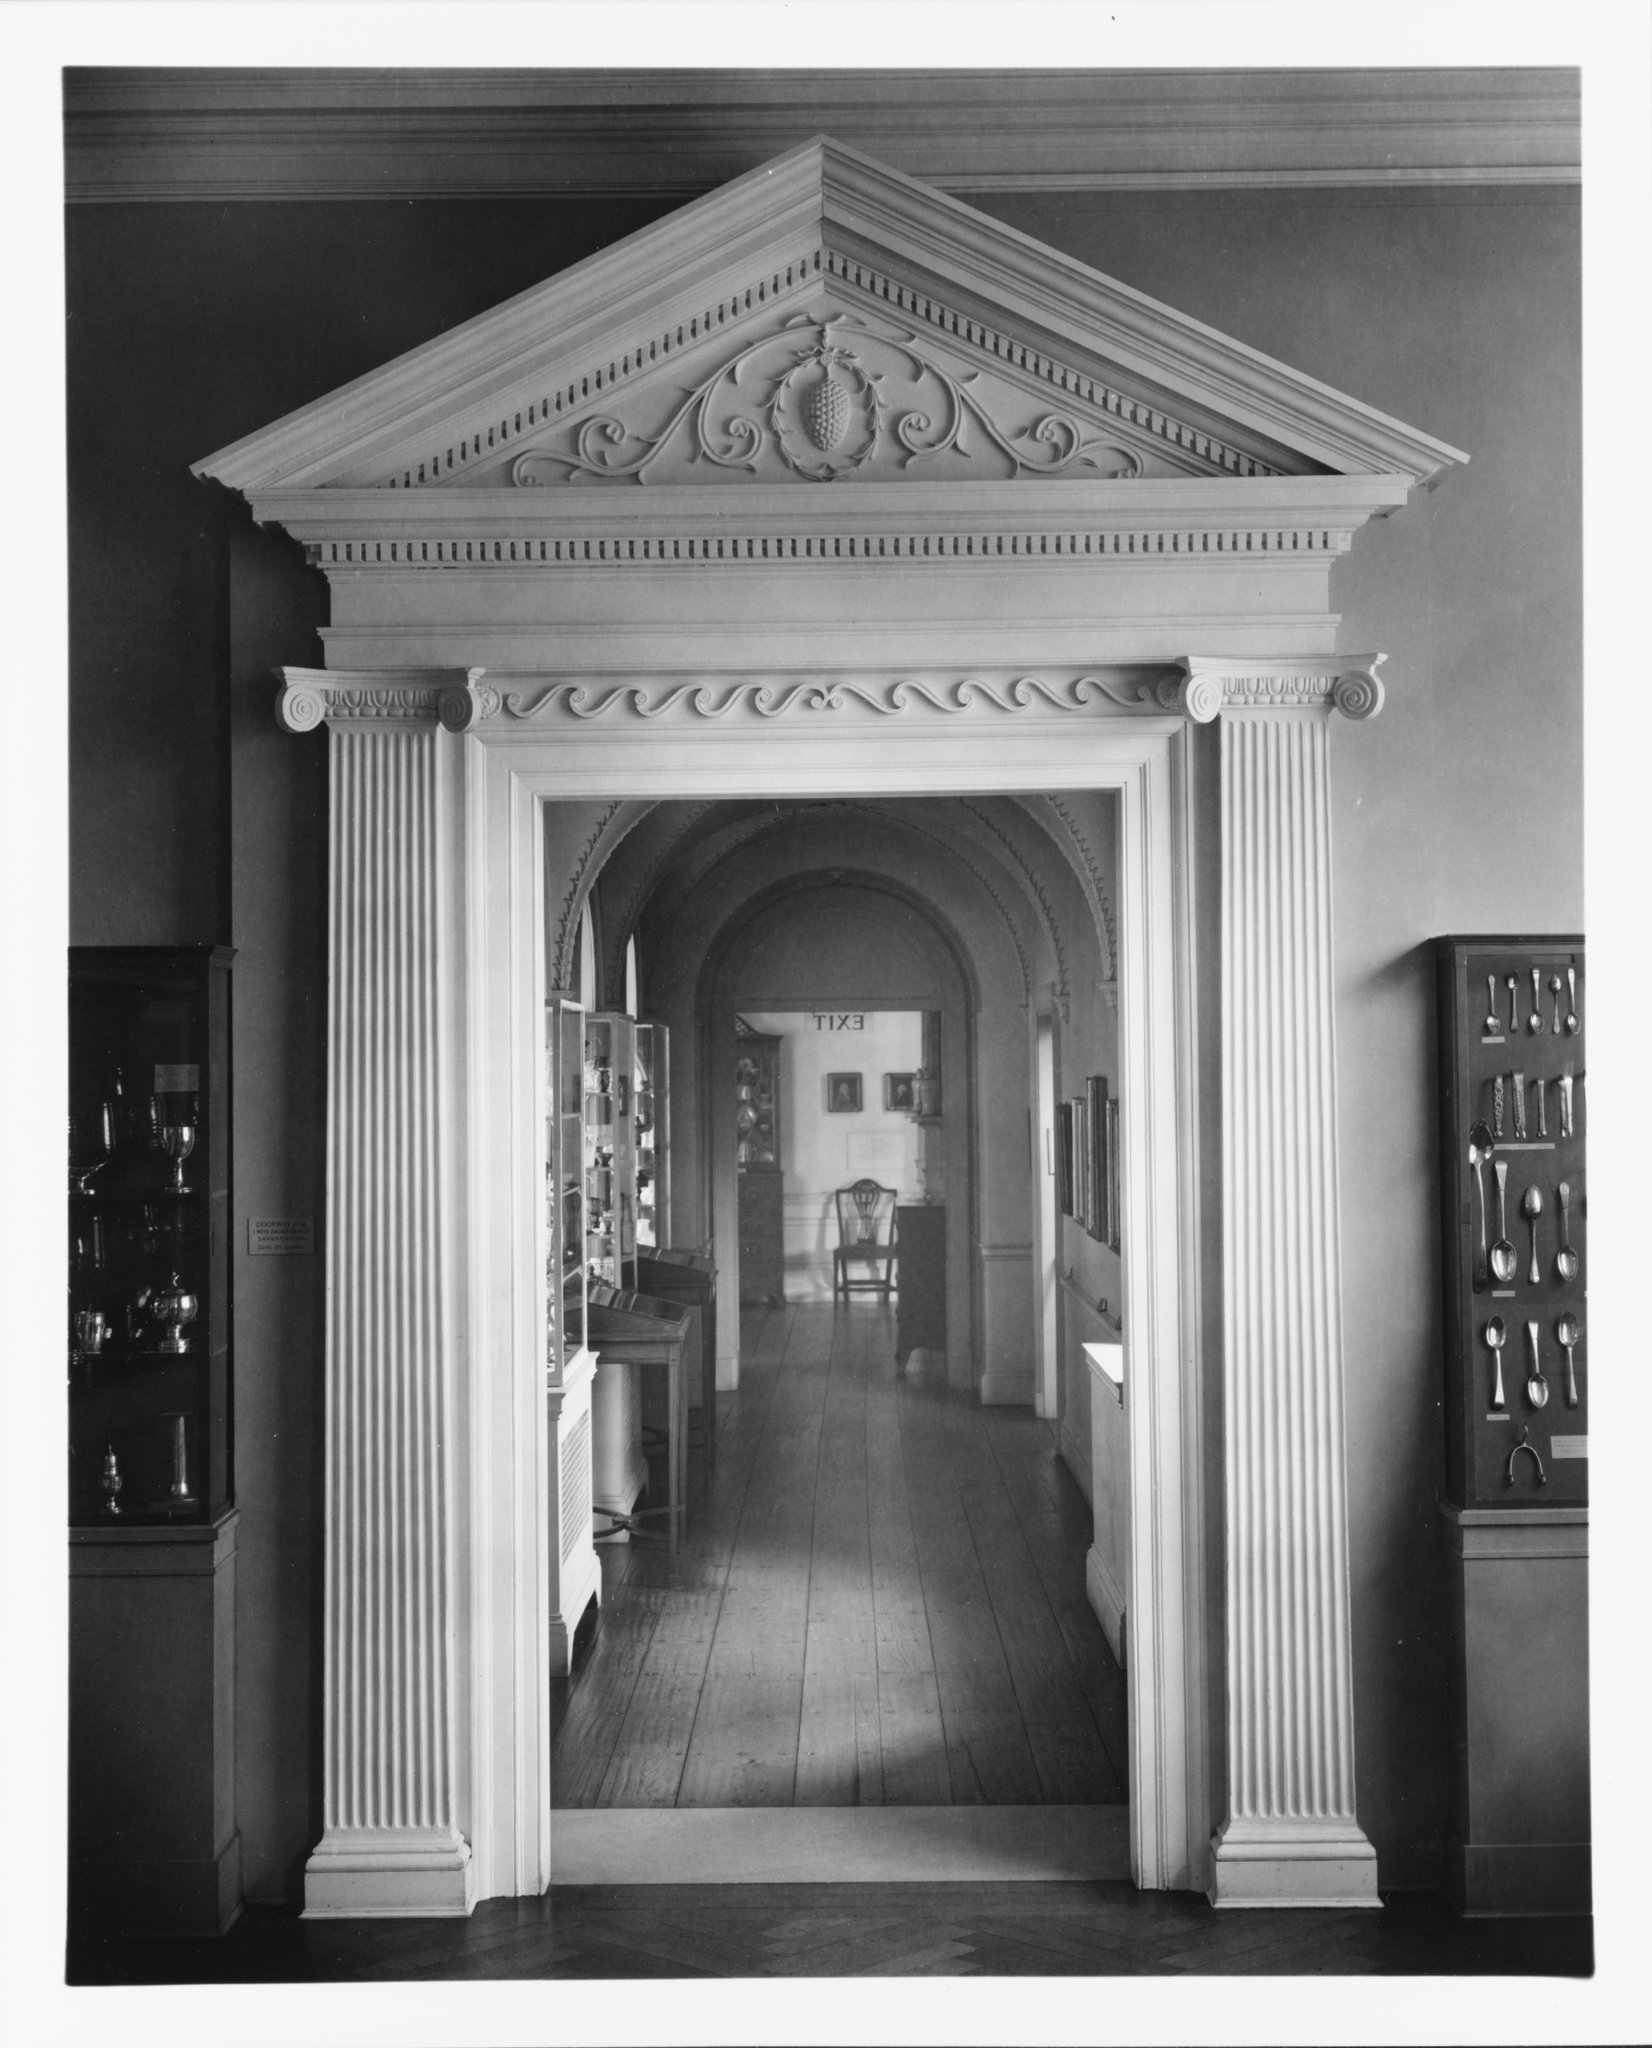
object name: exterior doorway from one west broad street, savannah, georgia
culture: american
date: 1800-1805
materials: wood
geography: united states